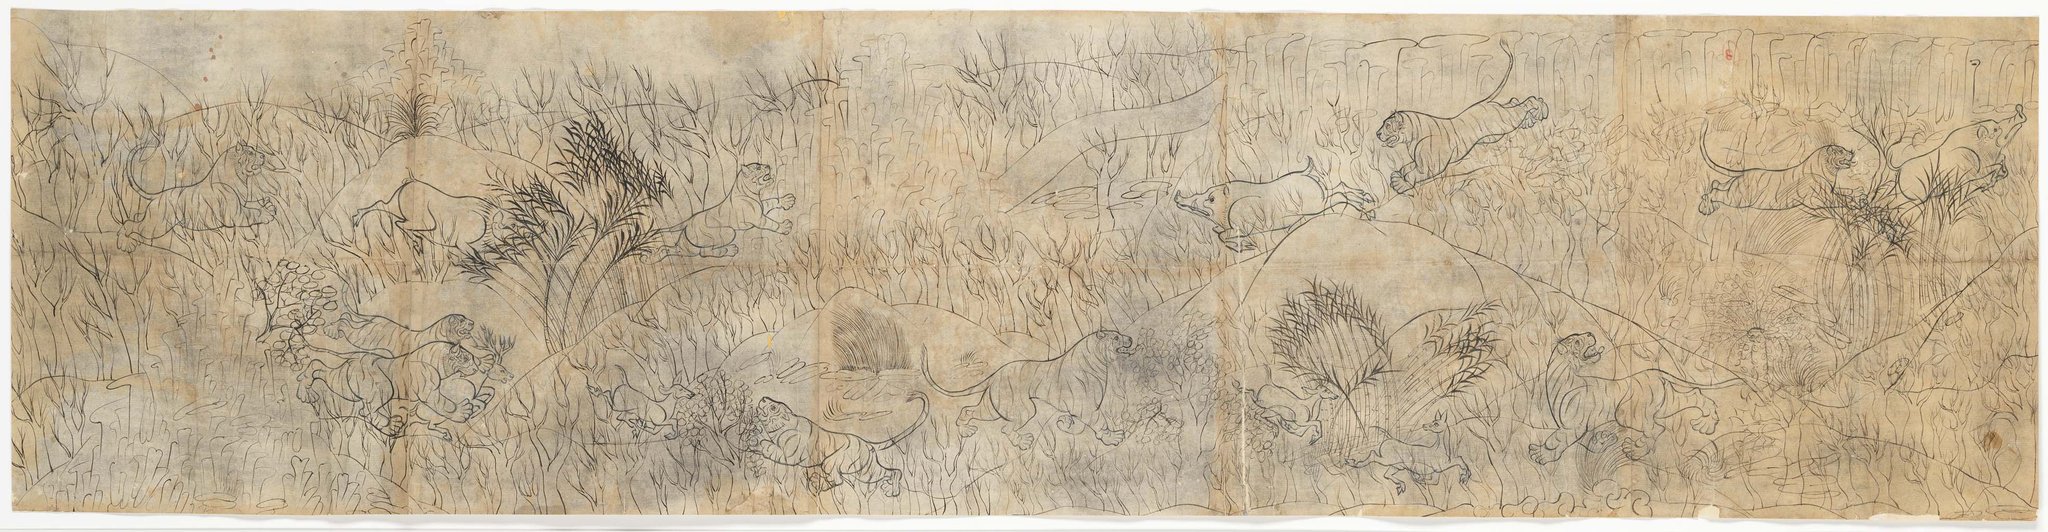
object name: painting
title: Tigers Hunting Boars and Deer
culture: indian, rajasthani, kota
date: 1830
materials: ink, paper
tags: hunting,boars,deer,tigers